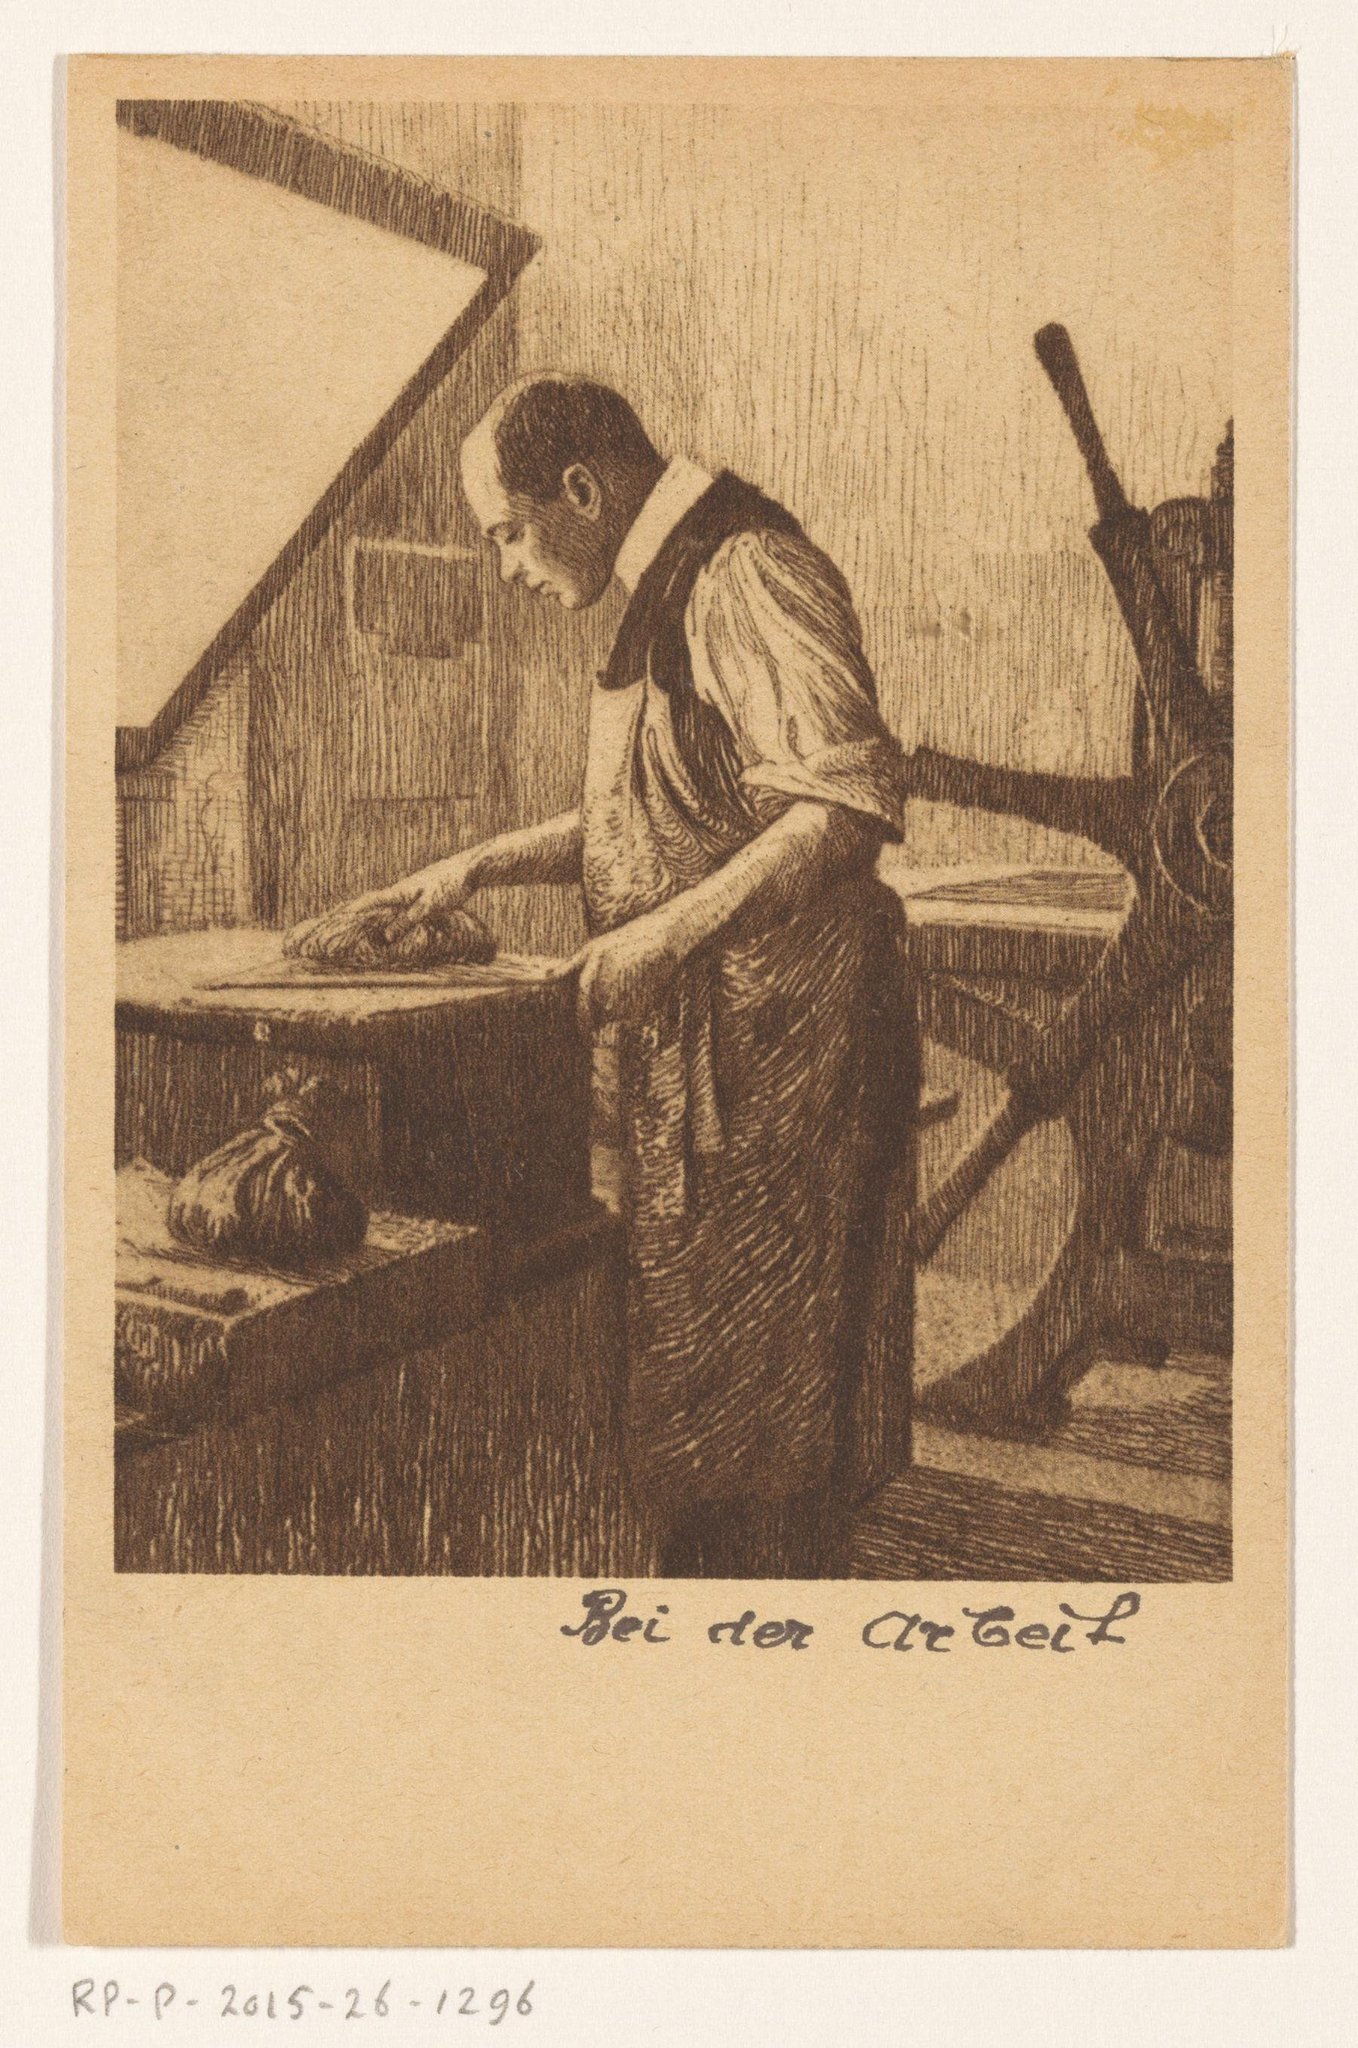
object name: print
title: Bei der Arbeit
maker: Anonymous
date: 1922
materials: paper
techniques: photochemical processes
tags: painter, print maker, draughtsman, ephraim moshe lilien, artist at work, in his workshop (+ graphic arts), printing press, portrait, self-portrait of graphic artist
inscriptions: collector's mark: Lugt 4780, collector's mark: Lugt 2228, inscription: ‘Bei der Arbeit’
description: Ephraim Moshe Lilien in zijn atelier, bezig met het schoonmaken van een koperplaat. In de achtergrond een plaatpers.